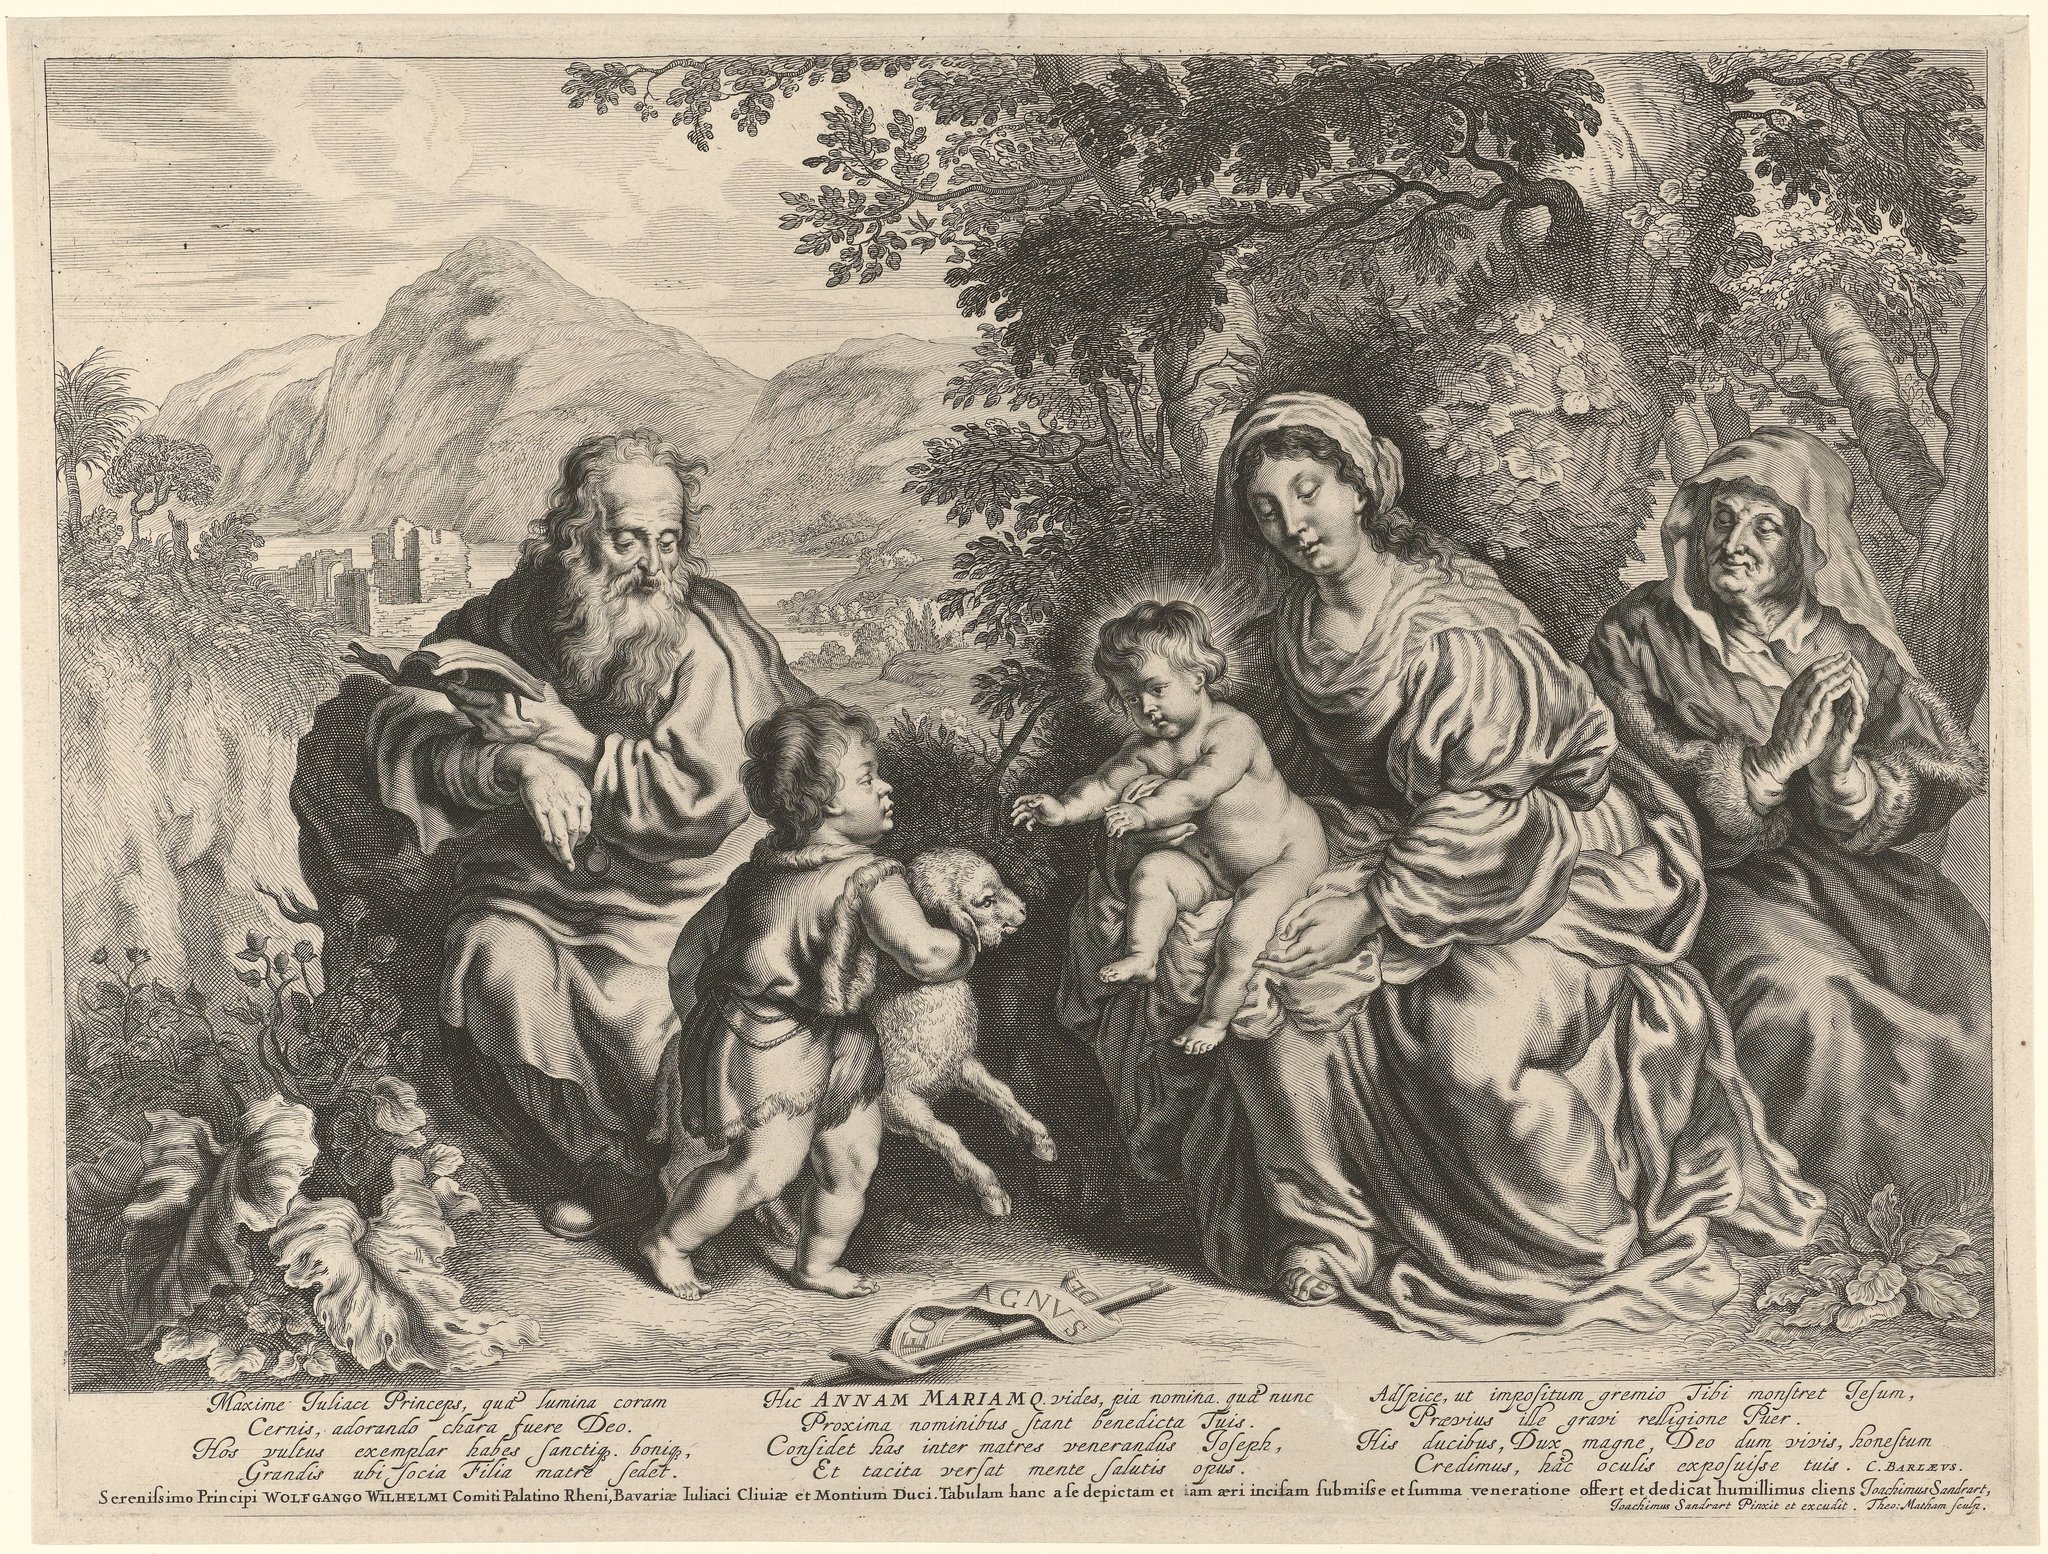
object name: print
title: De Heilige Familie met Elisabet en Johannes de Doper in landschap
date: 1630-1676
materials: paper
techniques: engraving, etching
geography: northern netherlands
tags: holy family with john the baptist (as child)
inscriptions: collector's mark: Lugt 240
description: De Heilige Familie met Elisabet en Johannes de Doper in een landschap. Het kind Johannes draagt een lam naar het Christuskind. Links Jozef met een bril en een boek. Op de achtergrond een weids berglandschap.